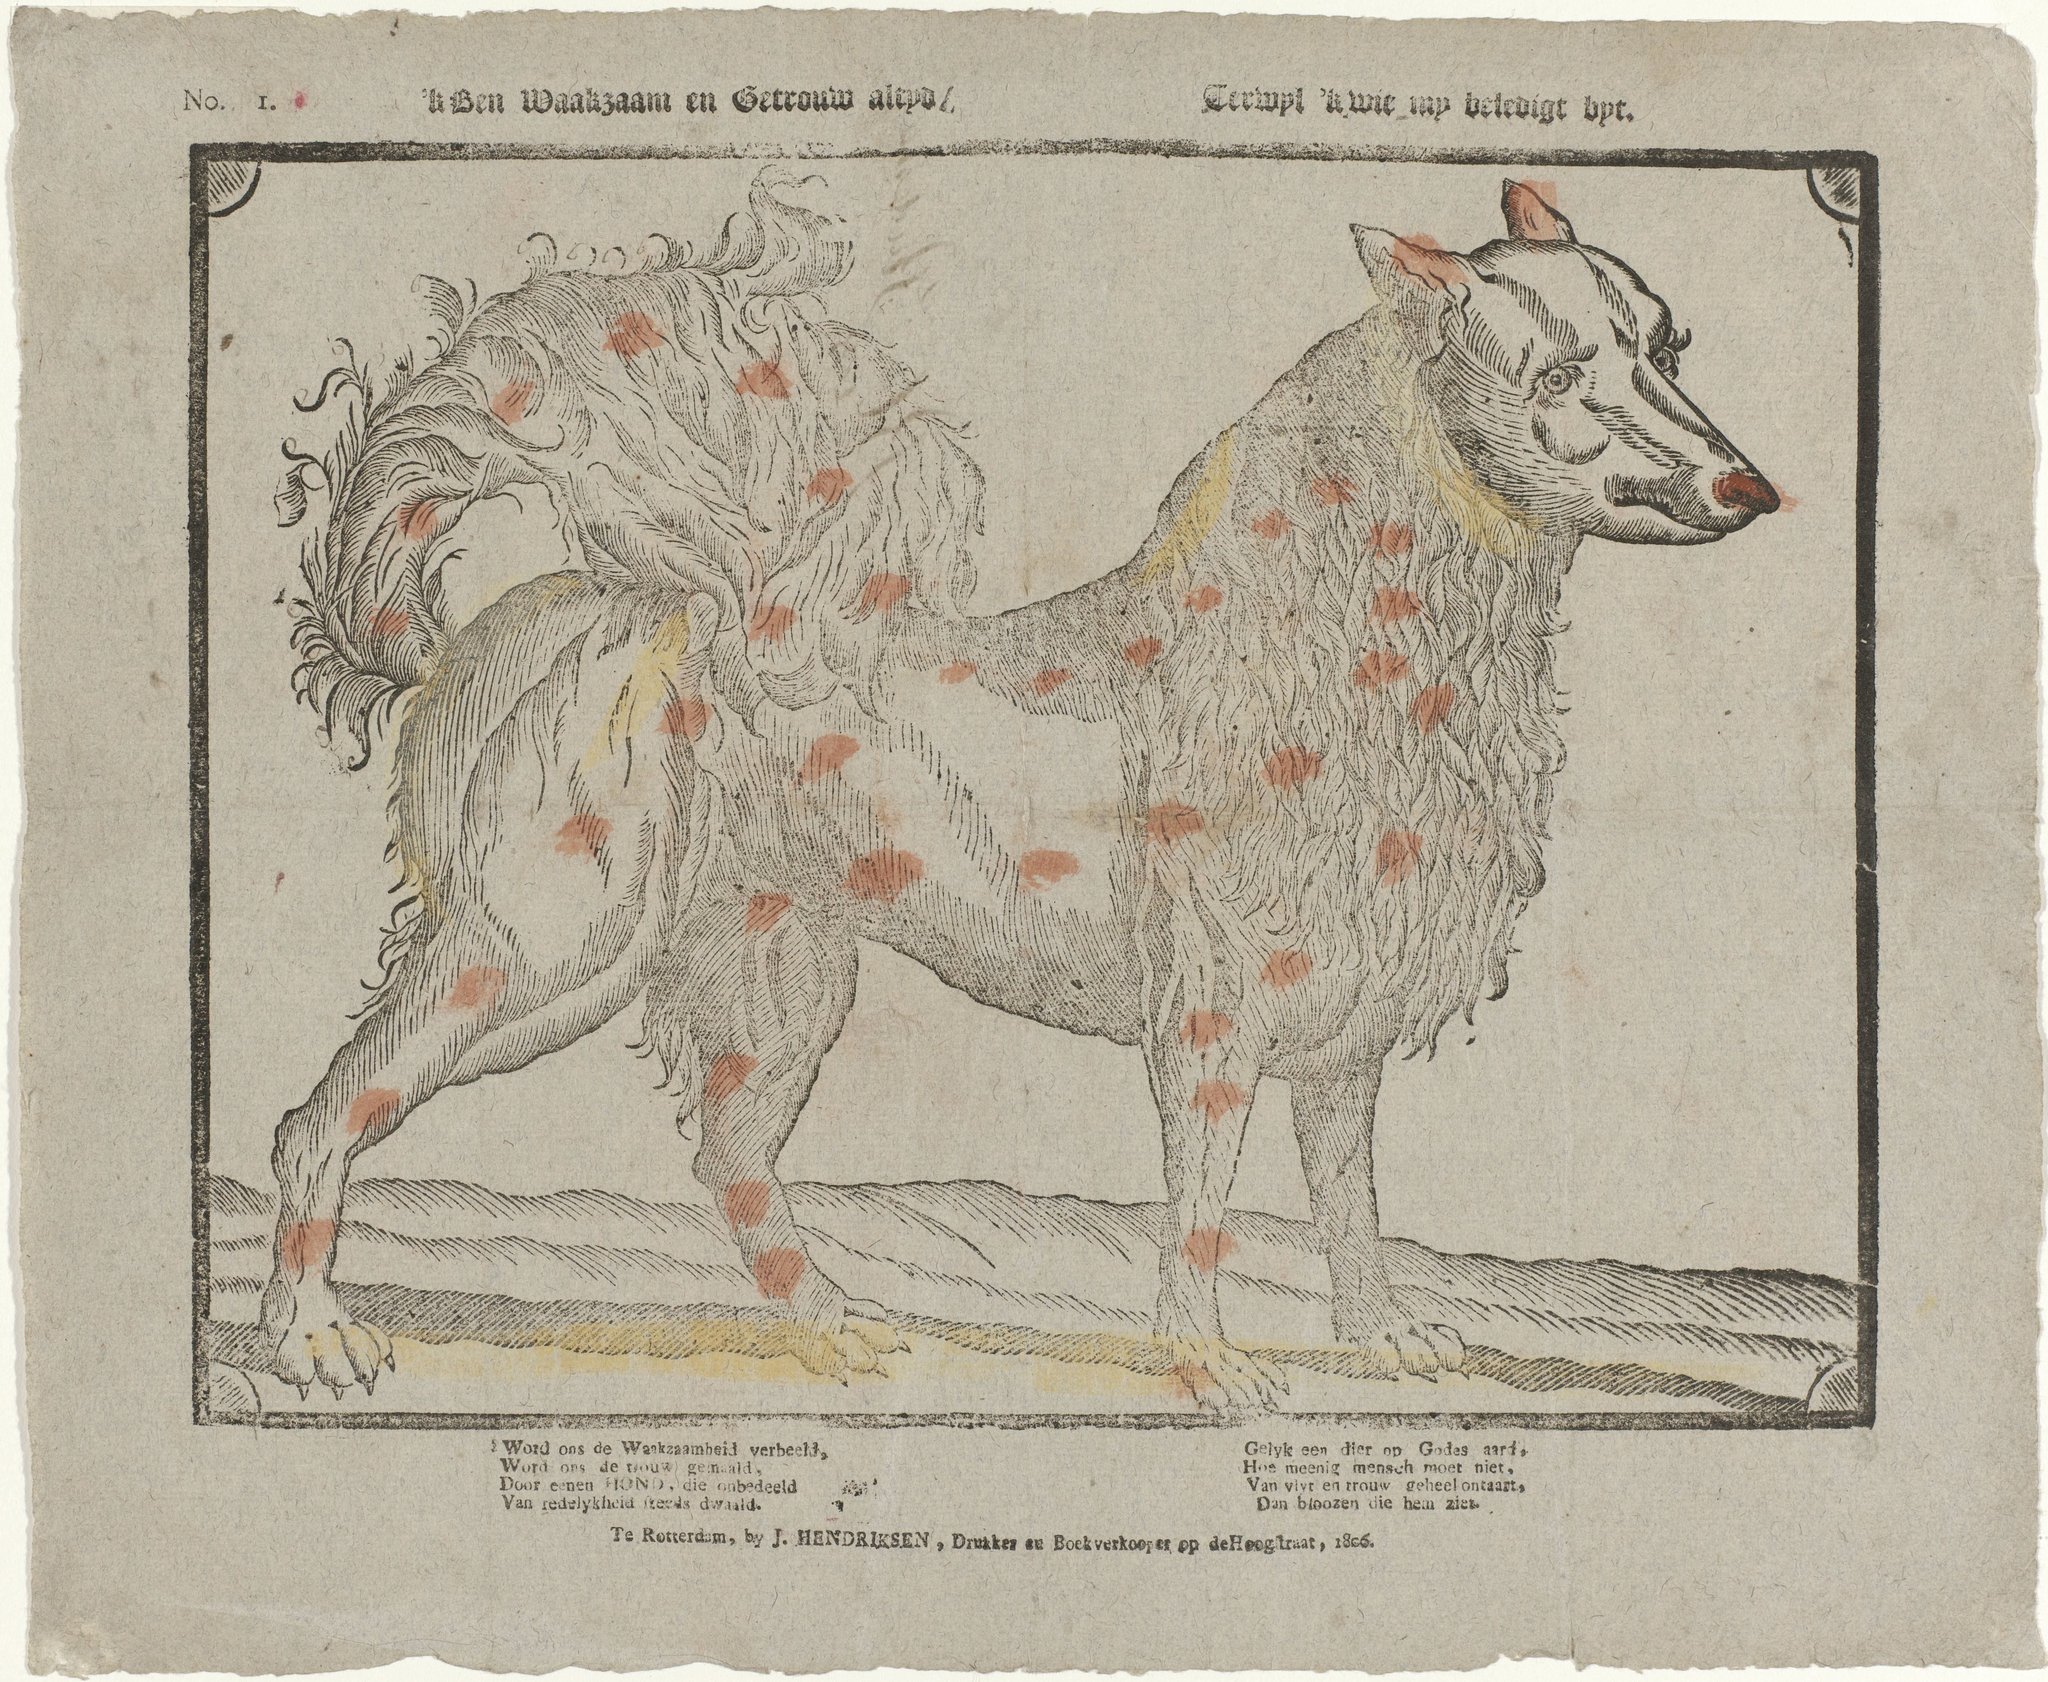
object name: popular print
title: 'k ben waakzaam en getrouw altyd / Terwyl 'k wie my beledigt byt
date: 1806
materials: paper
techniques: colour, letterpress printing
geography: netherlands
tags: dog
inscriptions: collector's mark: Lugt 2760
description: Blad met een grote voorstelling van een hond. In de ondermarge een achtregelig vers in twee kolommen. Genummerd linksboven: No. 1.